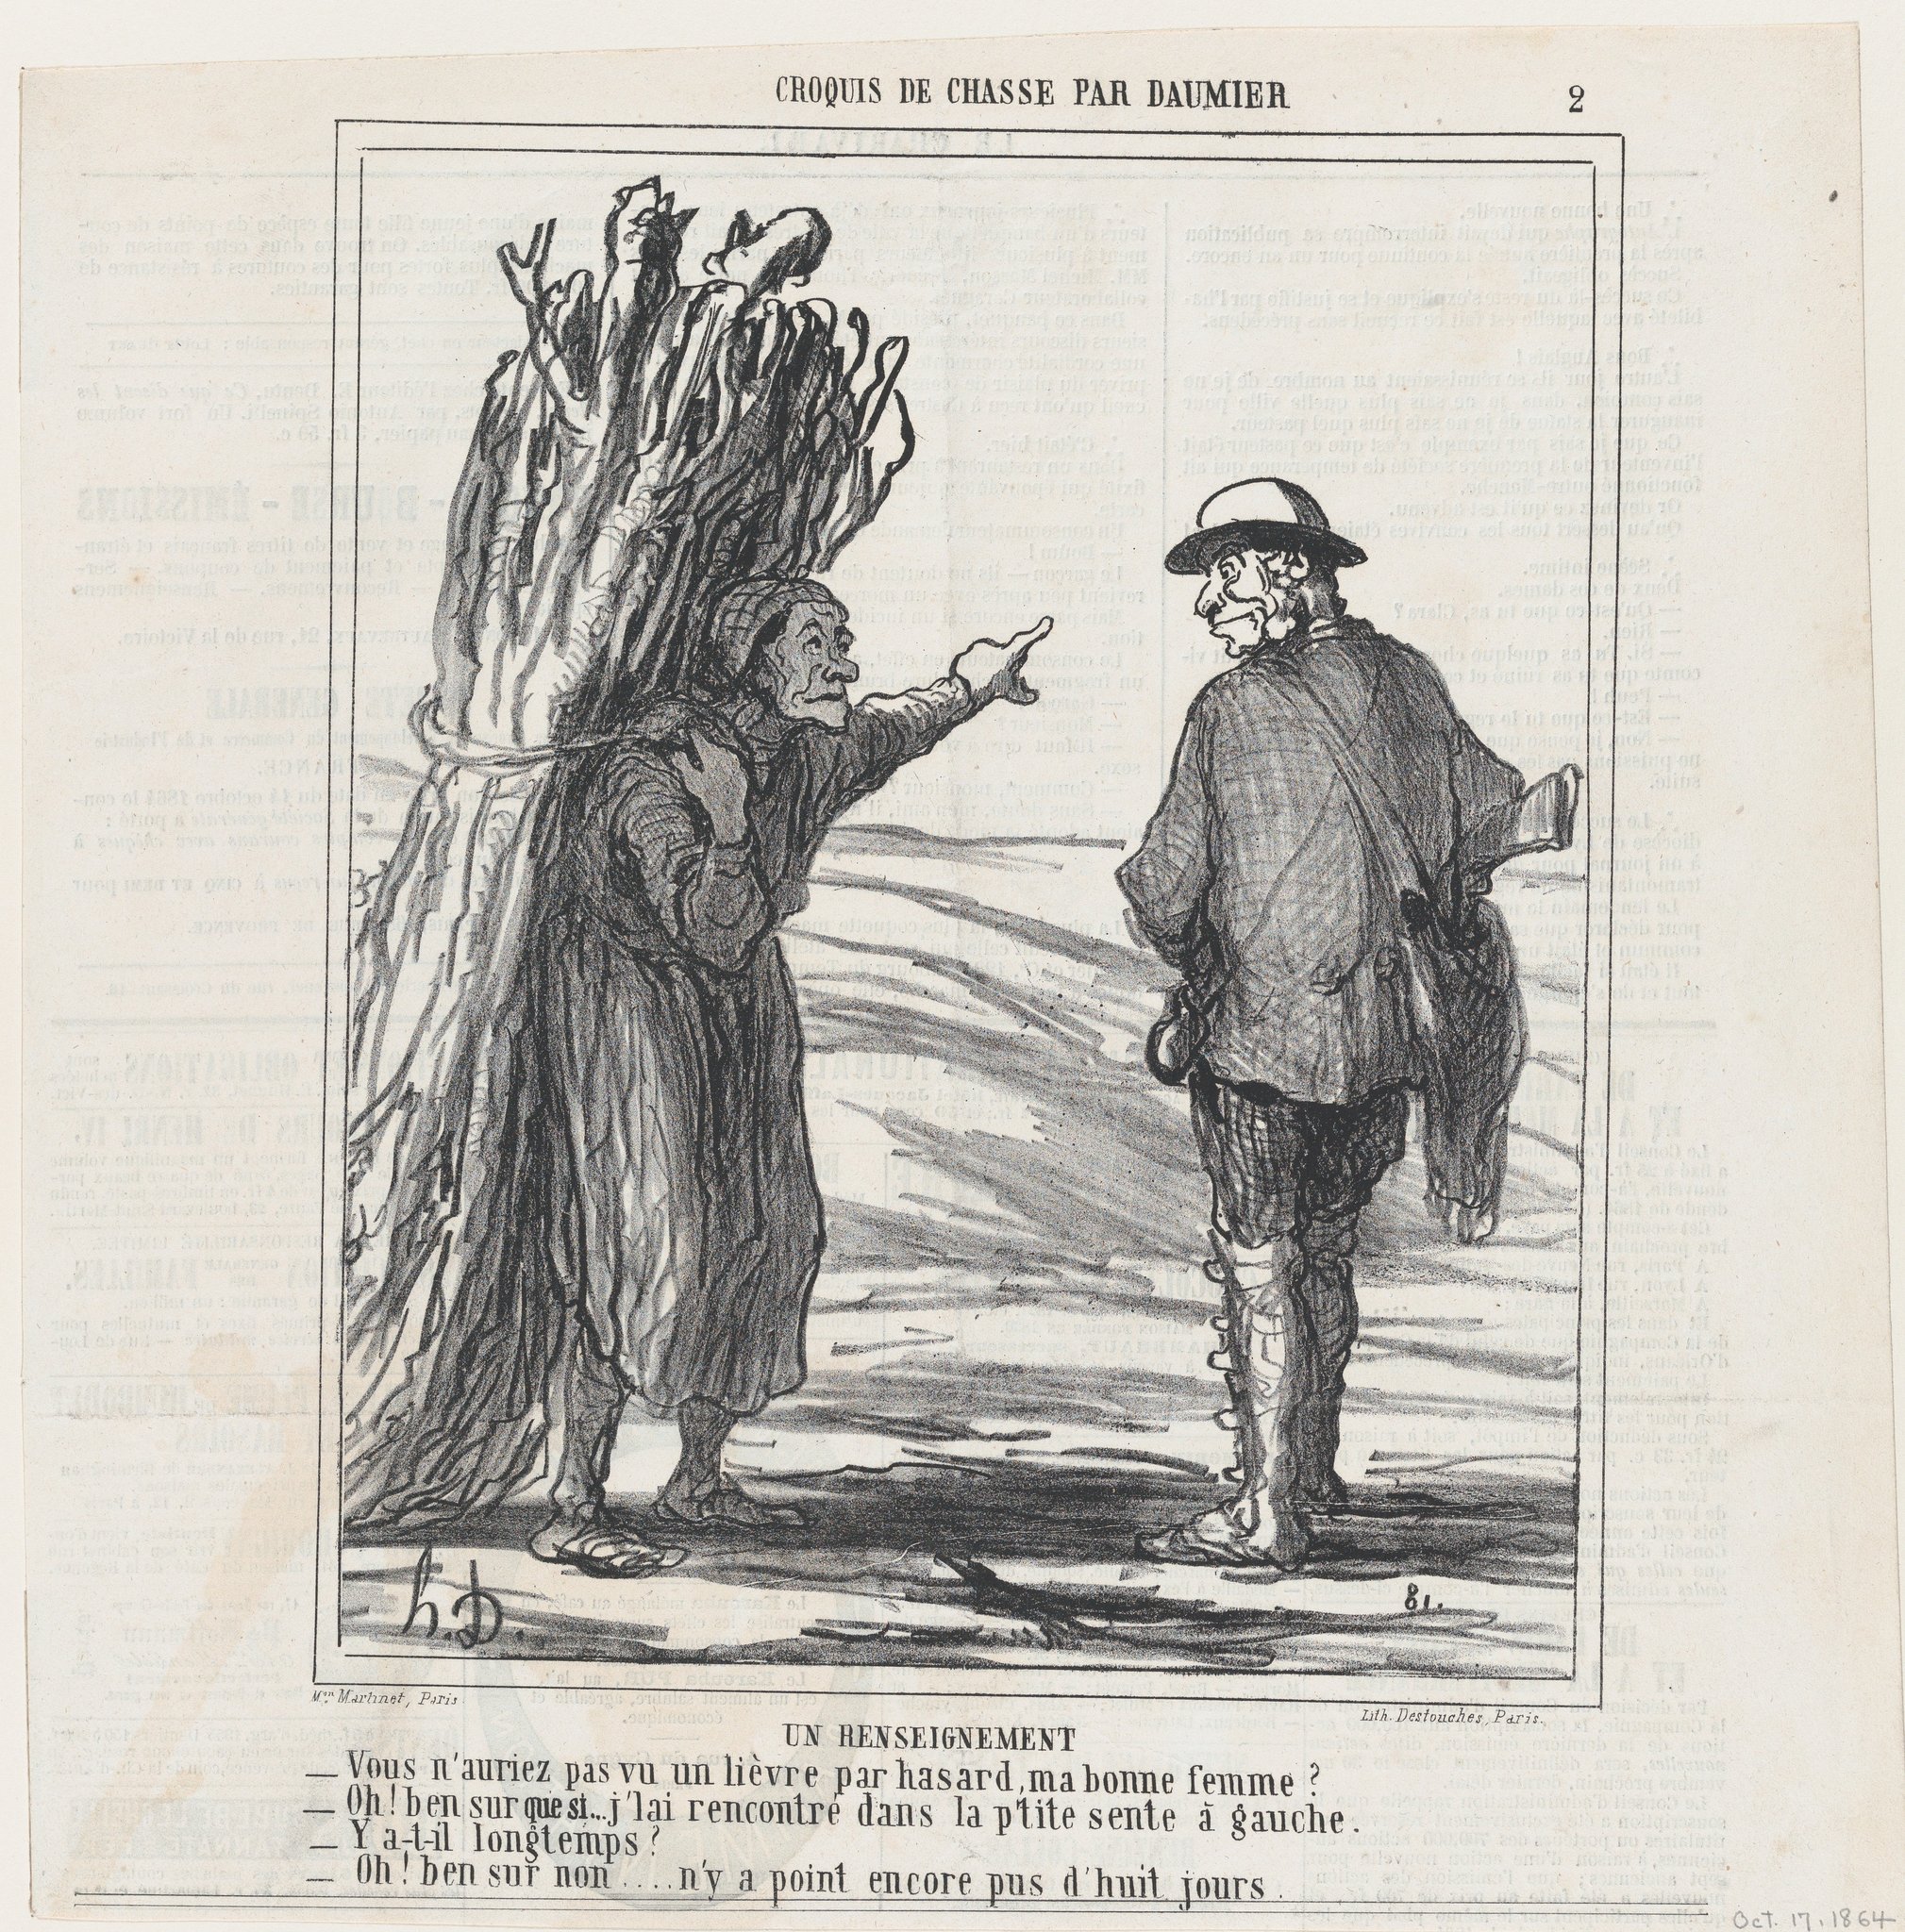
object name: print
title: Information, from 'Hunting sketches,' published in Le Chiavari, October 17, 1864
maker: honoré daumier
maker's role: artist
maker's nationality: french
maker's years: 1808-1879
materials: paper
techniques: lithograph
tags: satire,men,women